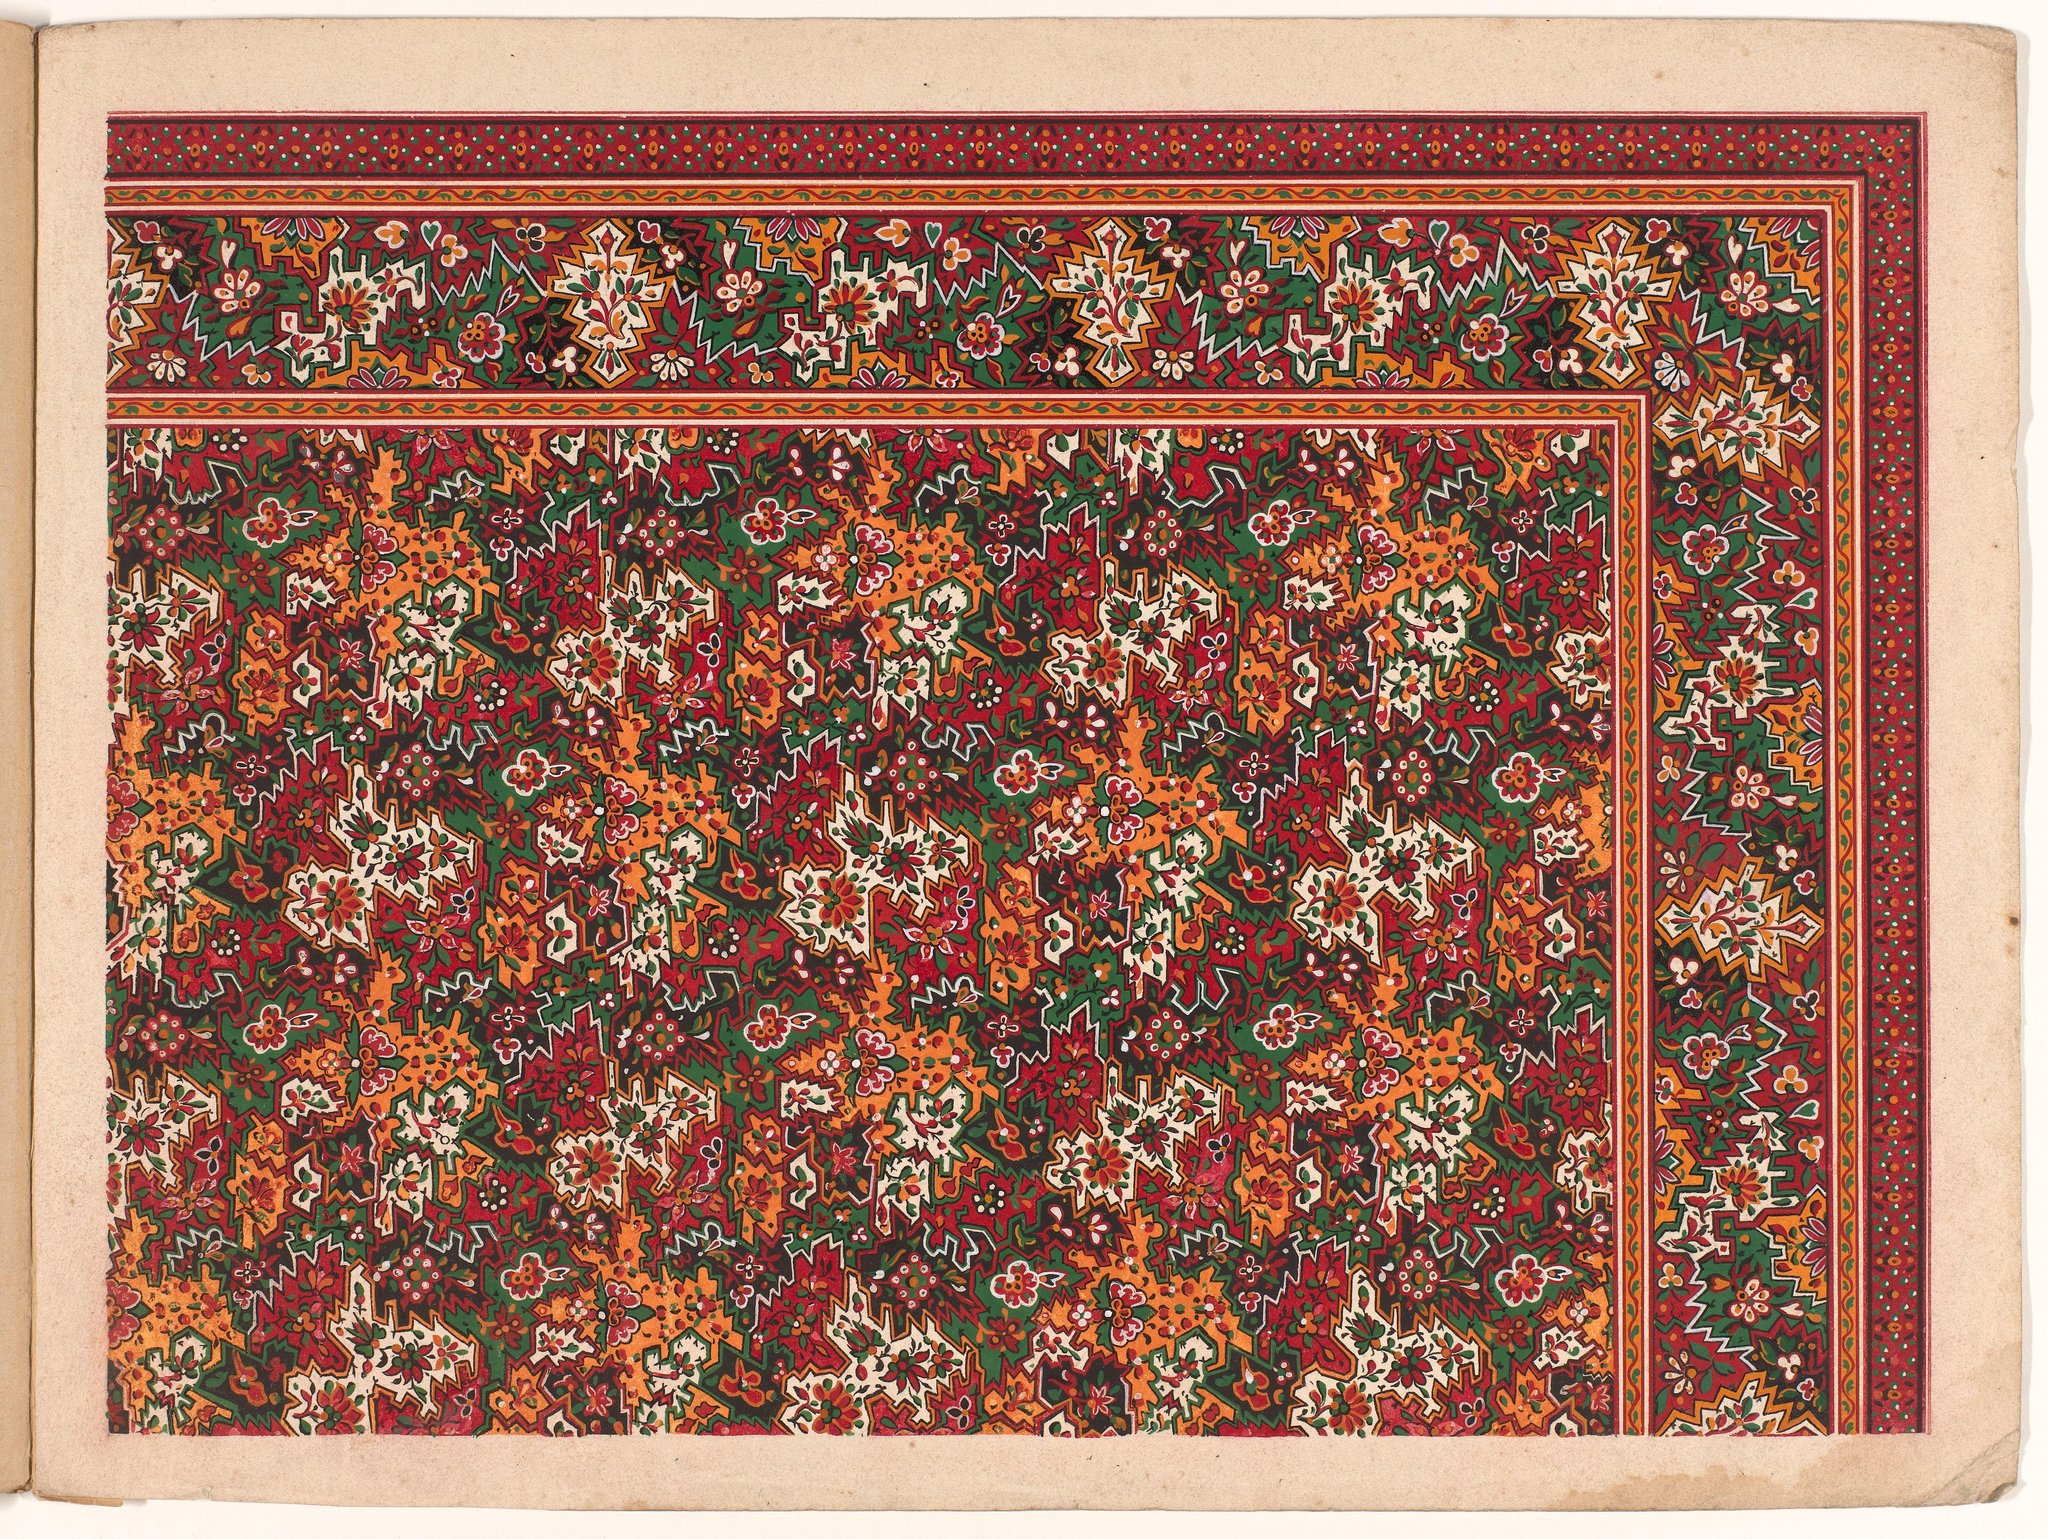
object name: drawing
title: Ontwerp voor een tapijt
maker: Anonymous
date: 1854-1864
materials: gouache, paper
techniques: brush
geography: deventer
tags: ornaments ~ art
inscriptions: retailer's mark: ‘JHS.’, inscription: ‘N s.’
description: De presentatietekeningen BK-1971-77-1 t/m 86 zijn kopieën van de originele ontwerptekeningen. Ze werden gemaakt voor vertegenwoordigers van bijvoorbeeld magazijnen, die ze aan hun klanten konden tonen. De meeste tekeningen tonen een kwart van het dessin inclusief rand, middenpartij (de zogenaamde grond of fond) en centraal medaillon. Door het gebruik van spiegels kan de illusie van het gehele tapijt worden opgeroepen. Een deel van de tekeningen heeft een alfabetische opeenvolgende letter als kenmerk, de andere groep een cijfer.Waarschijnlijk is de reeks dessins met een letter eerder samengesteld dan de genummerde tekeningen.